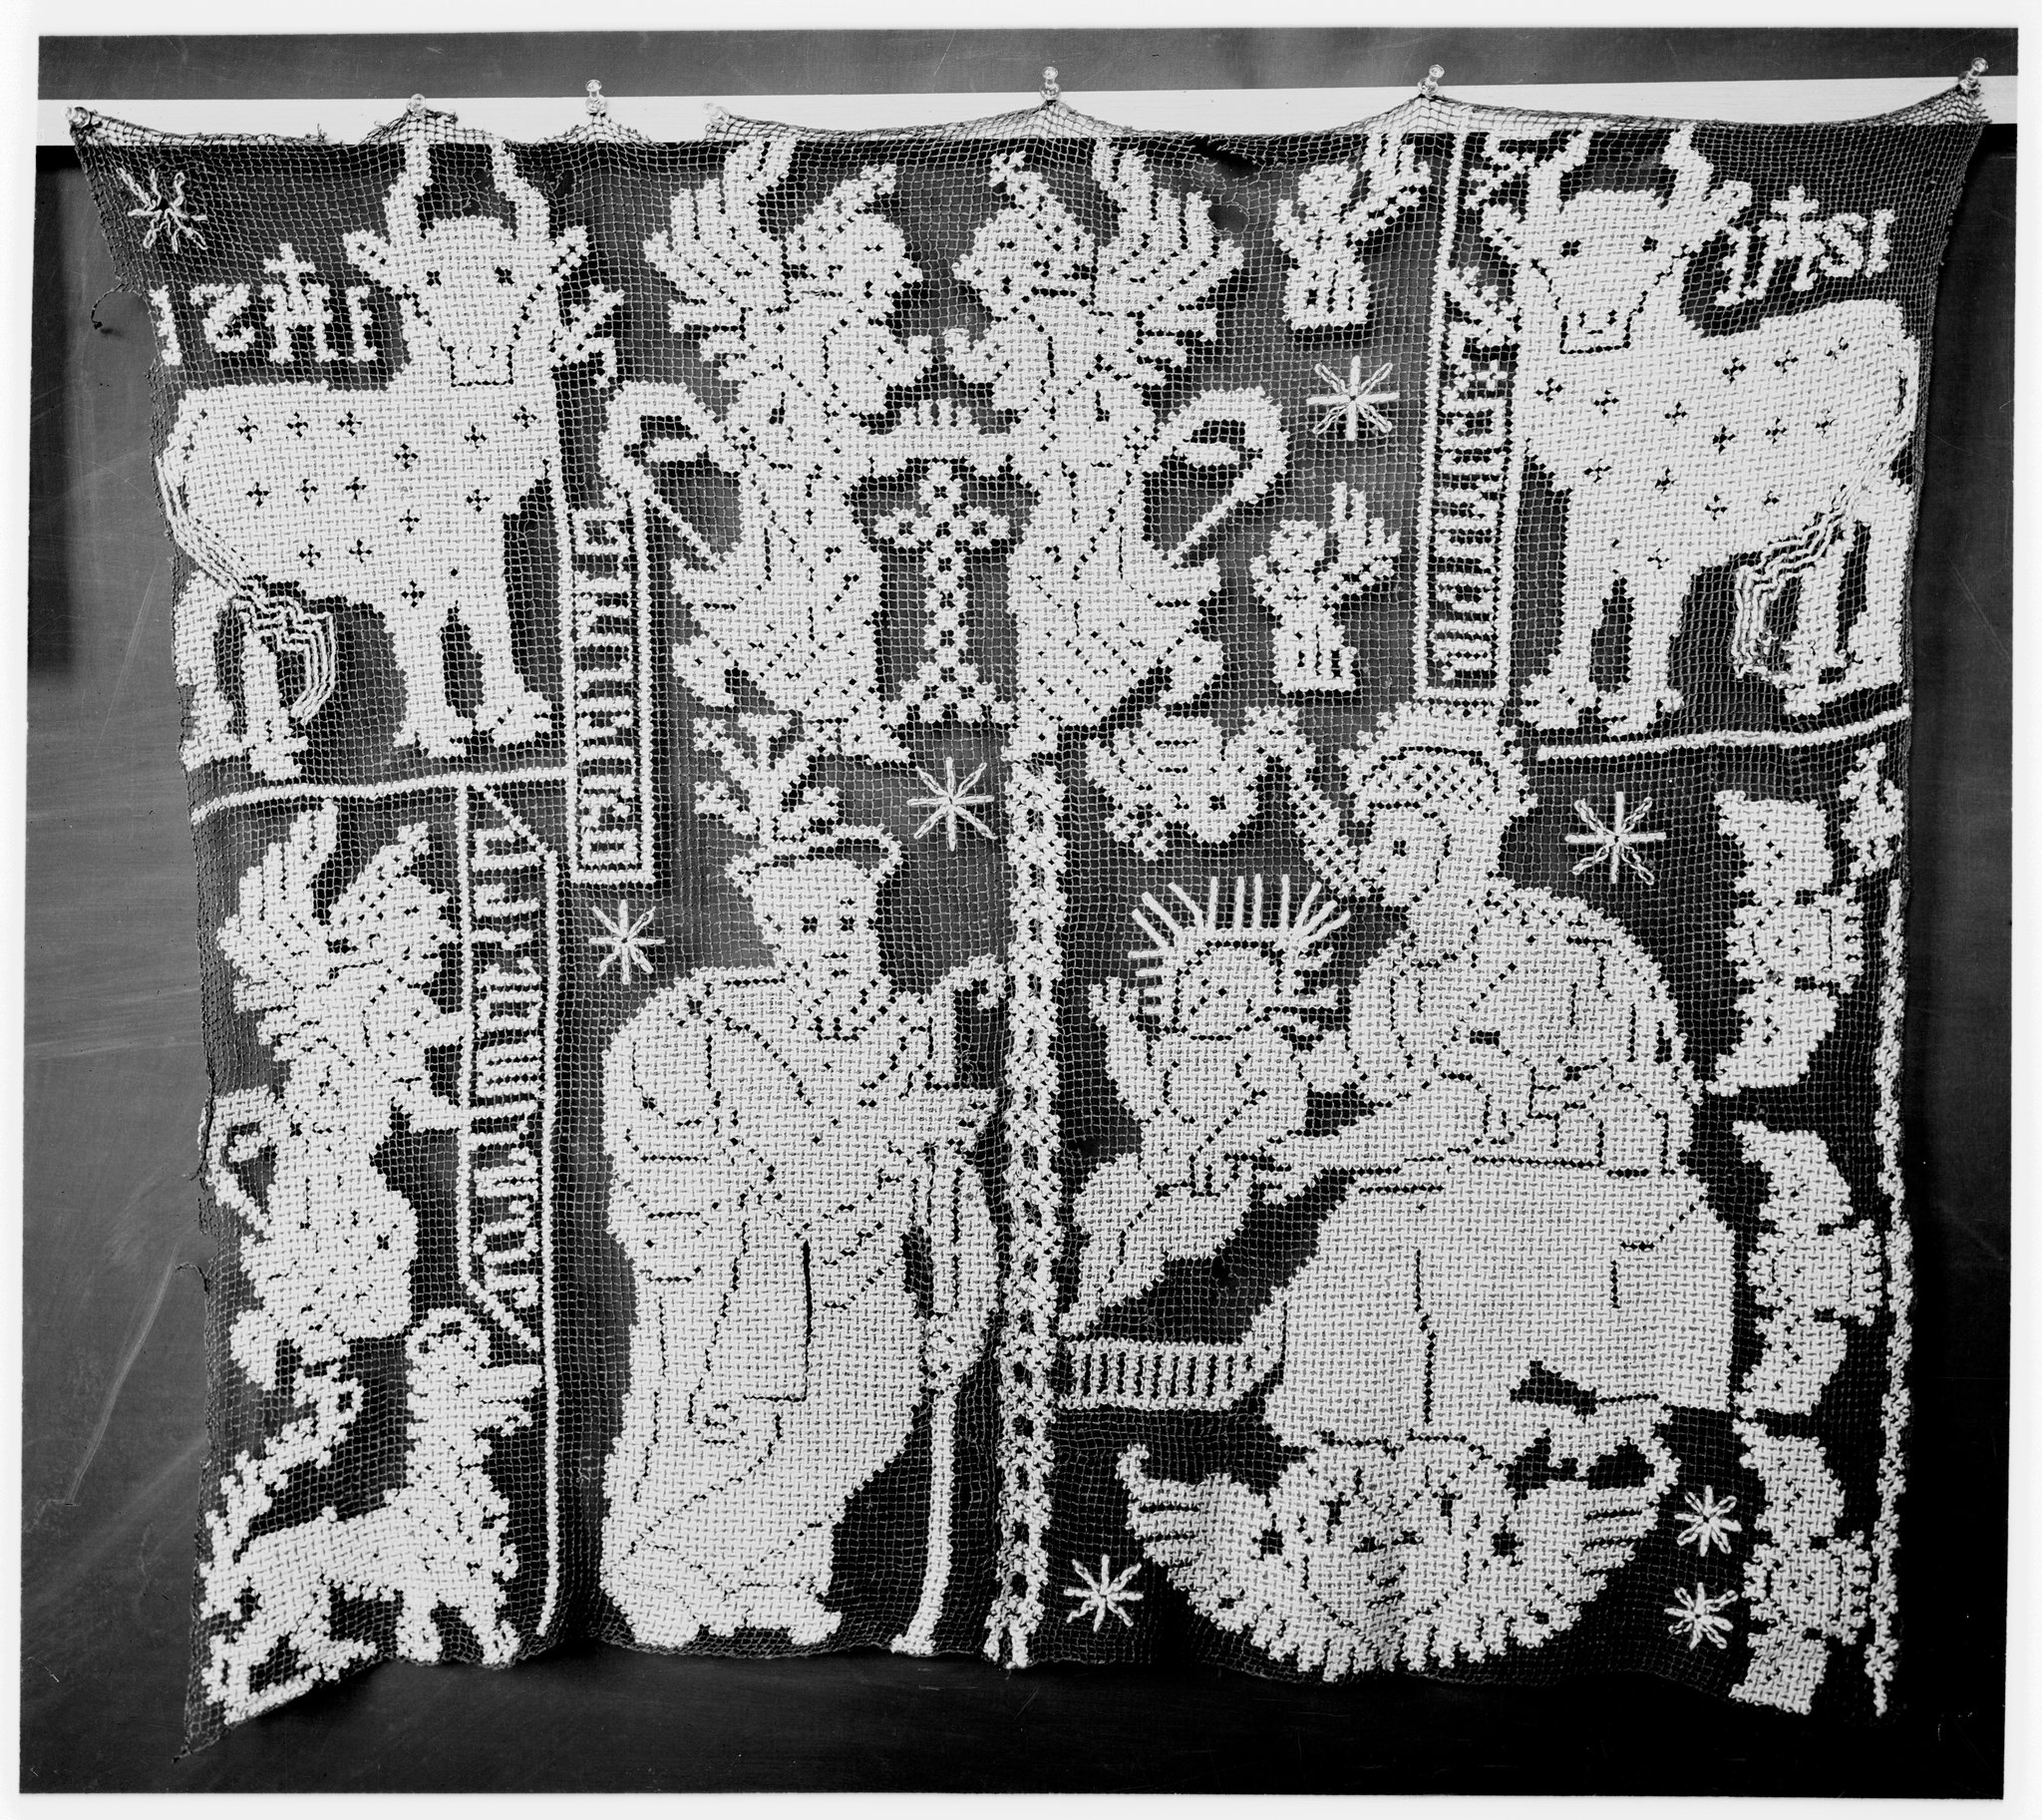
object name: panel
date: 1501-1600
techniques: embroidery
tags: bulls,madonna and child,nativity